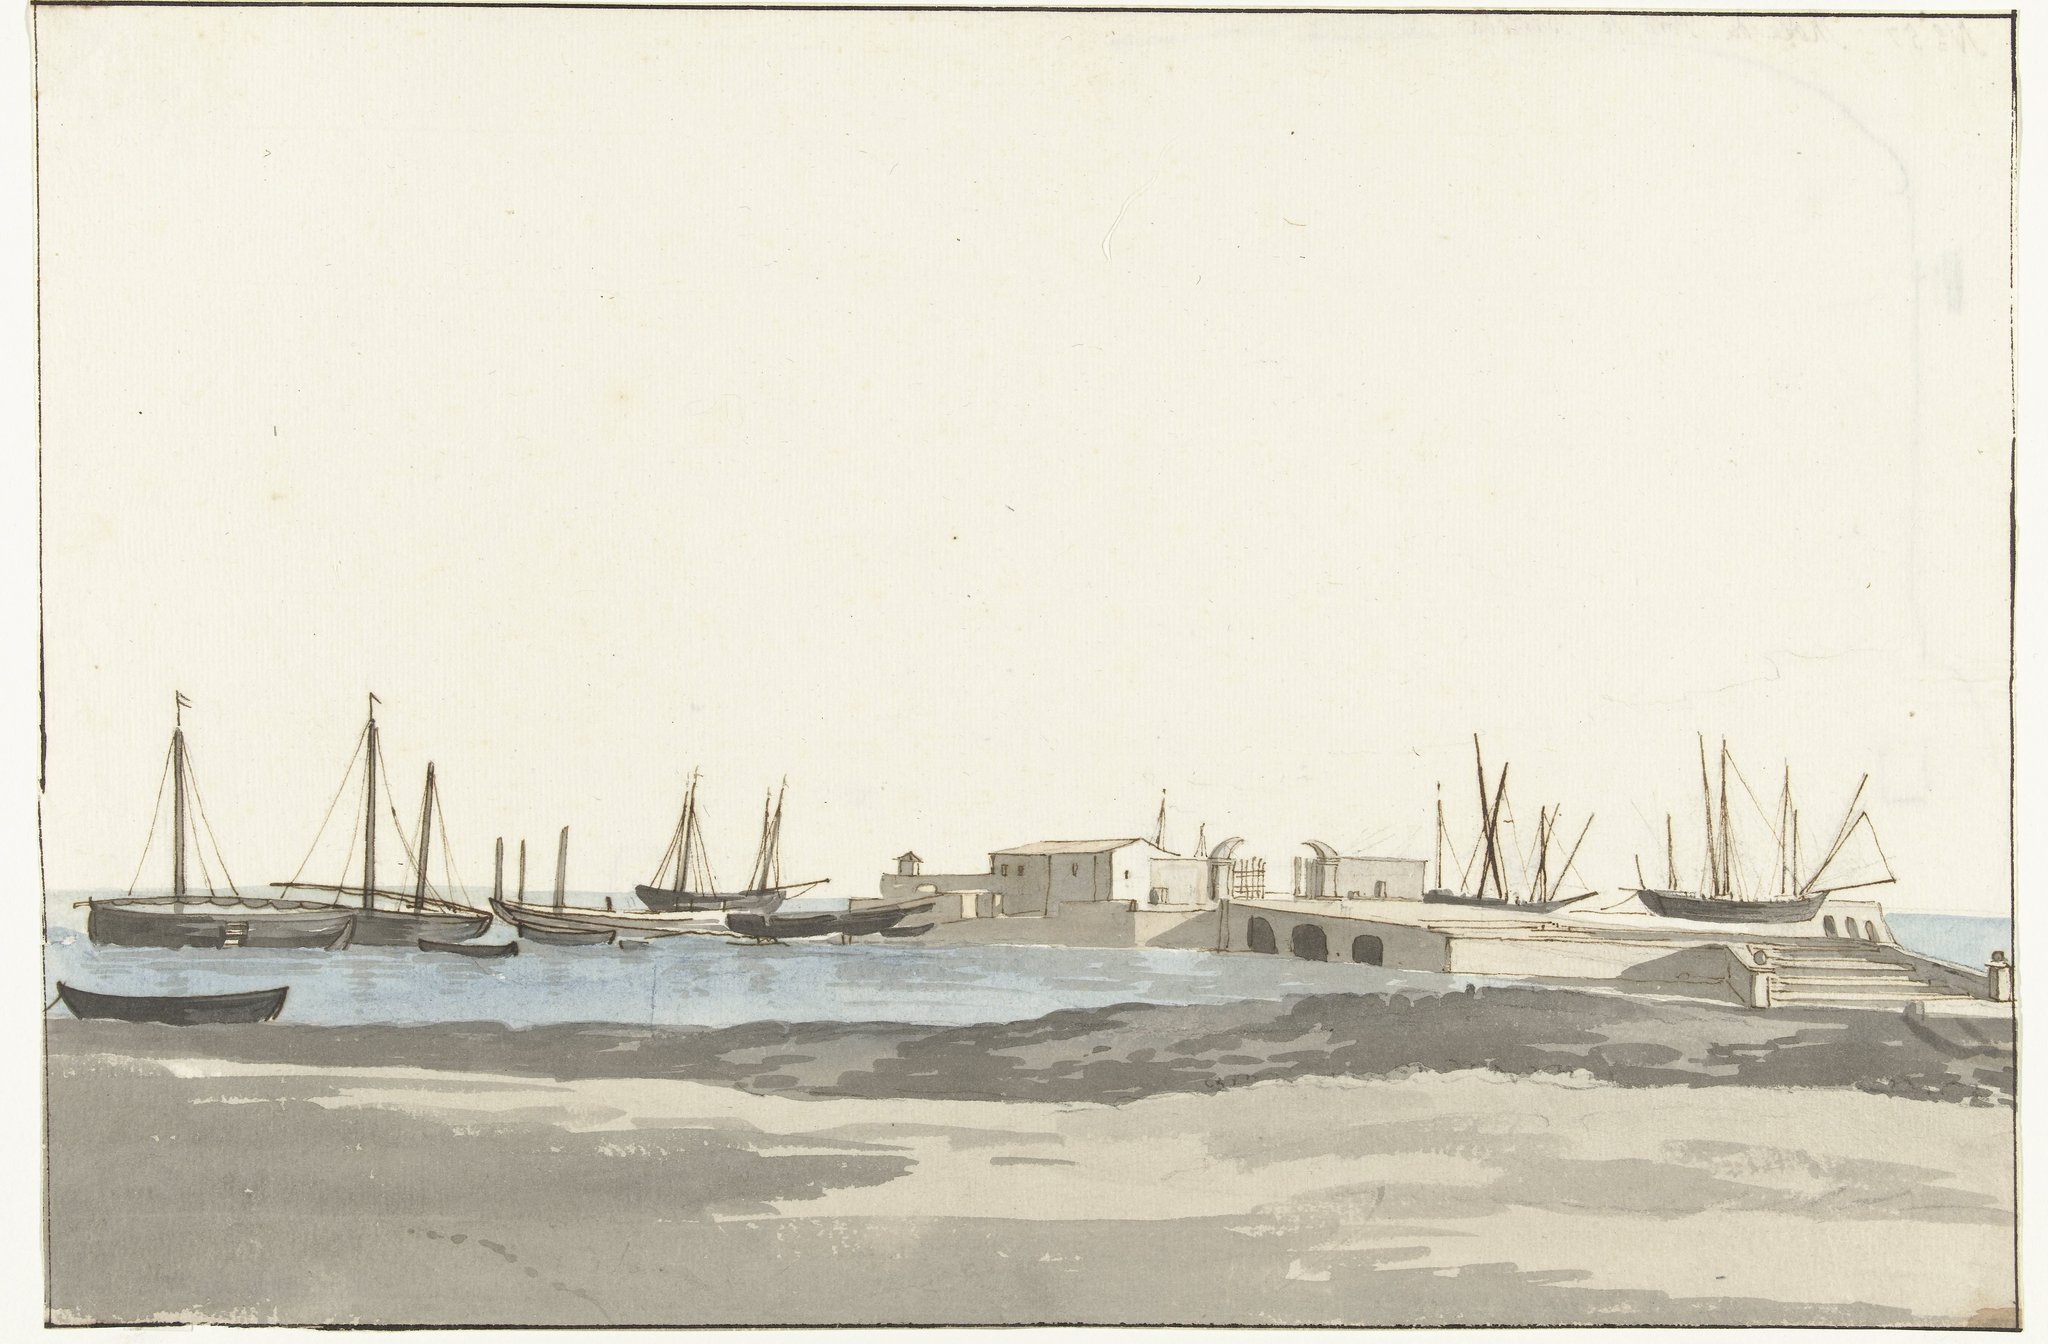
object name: watercolor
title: Mole du port de Barletta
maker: louis ducros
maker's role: draughtsman, print maker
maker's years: 1748-1810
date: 1778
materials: chalk, paper, watercolor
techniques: brush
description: Tekening uit het album 'Voyage en Italie, en Sicile et à Malte', 1778.